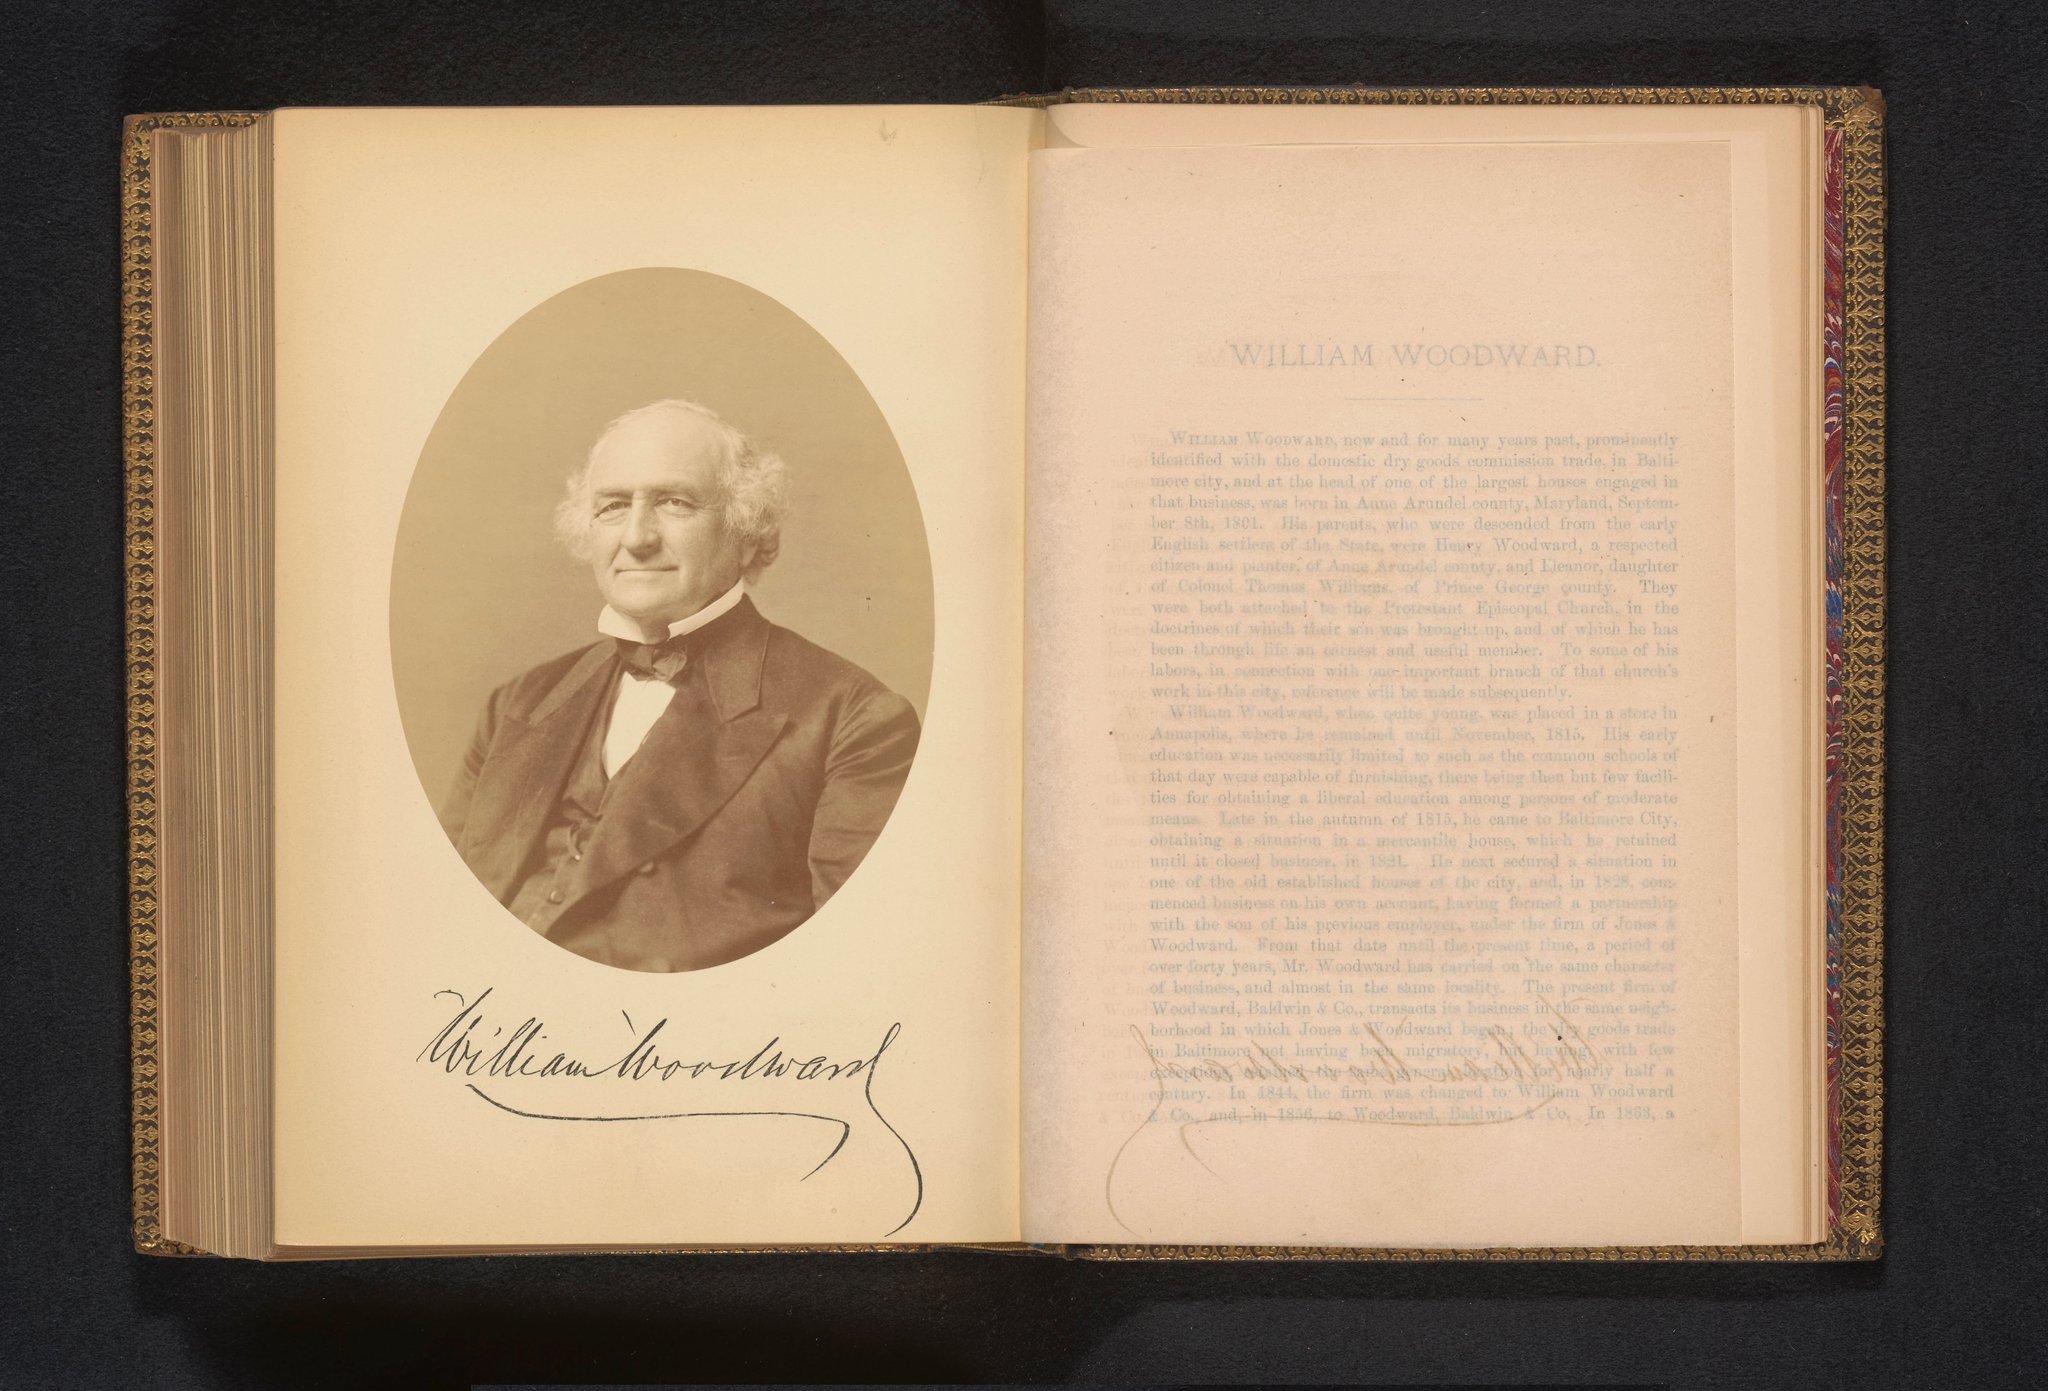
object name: page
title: Portret van William Woodward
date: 1866-1871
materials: photographic support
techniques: albumen print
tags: historical persons